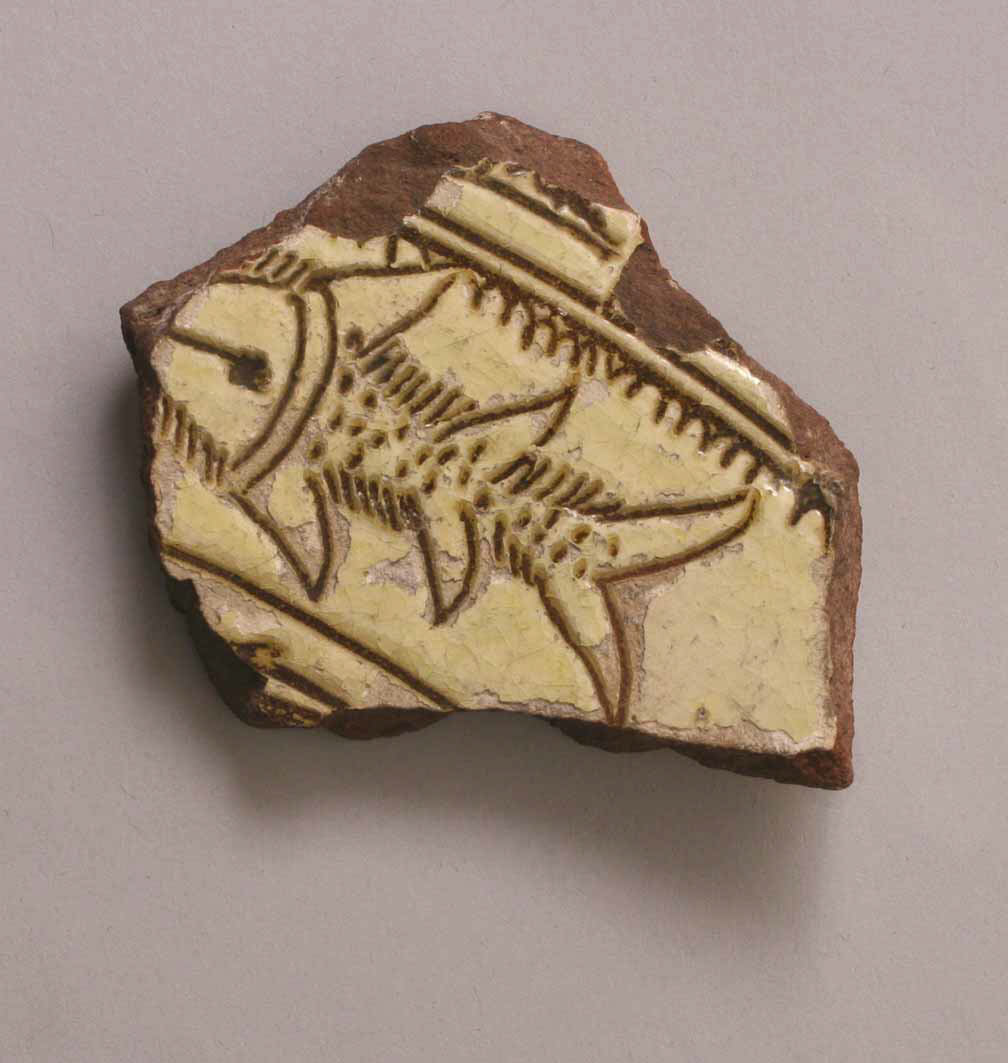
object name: fragment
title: Ceramic Fragment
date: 1301-1500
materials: earthenware, glaze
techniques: coloring, incising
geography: egypt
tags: fish